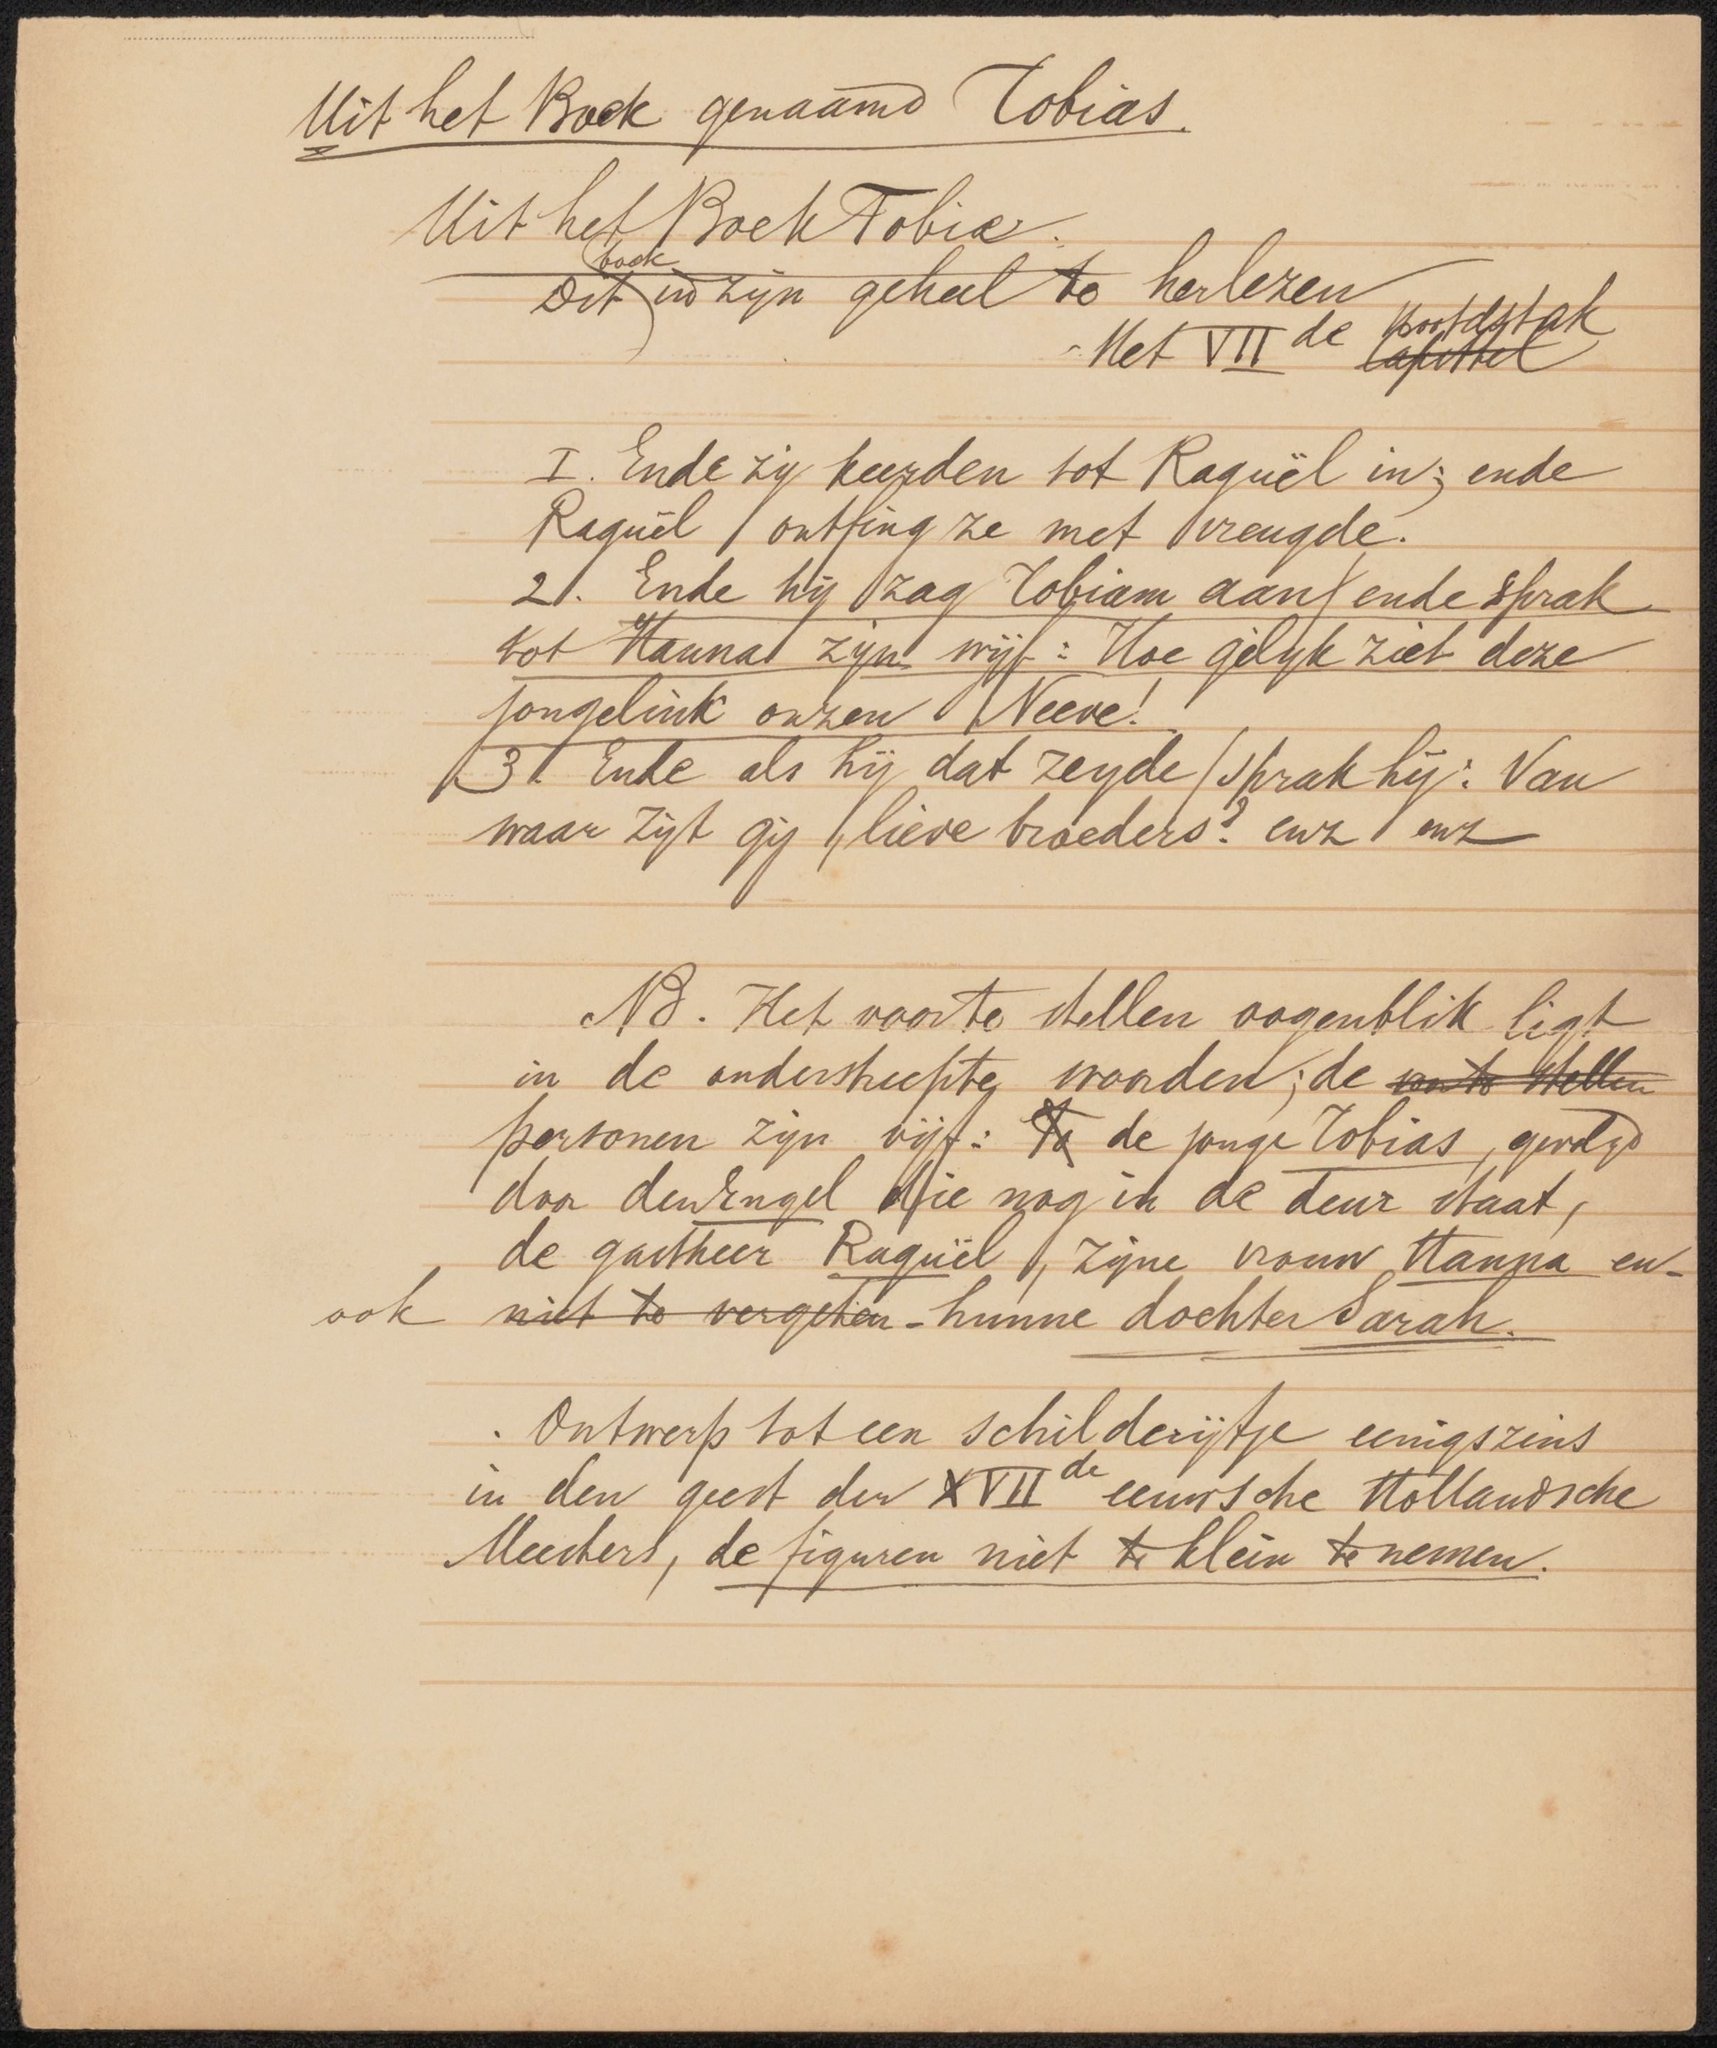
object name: aantekening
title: Aantekening uit collectie August Allebé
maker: august allebé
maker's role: draughtsman, print maker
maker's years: 1838-1927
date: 1848-1927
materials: ink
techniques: pen, writing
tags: painting (including book-illumination, miniature-painting), christian religion